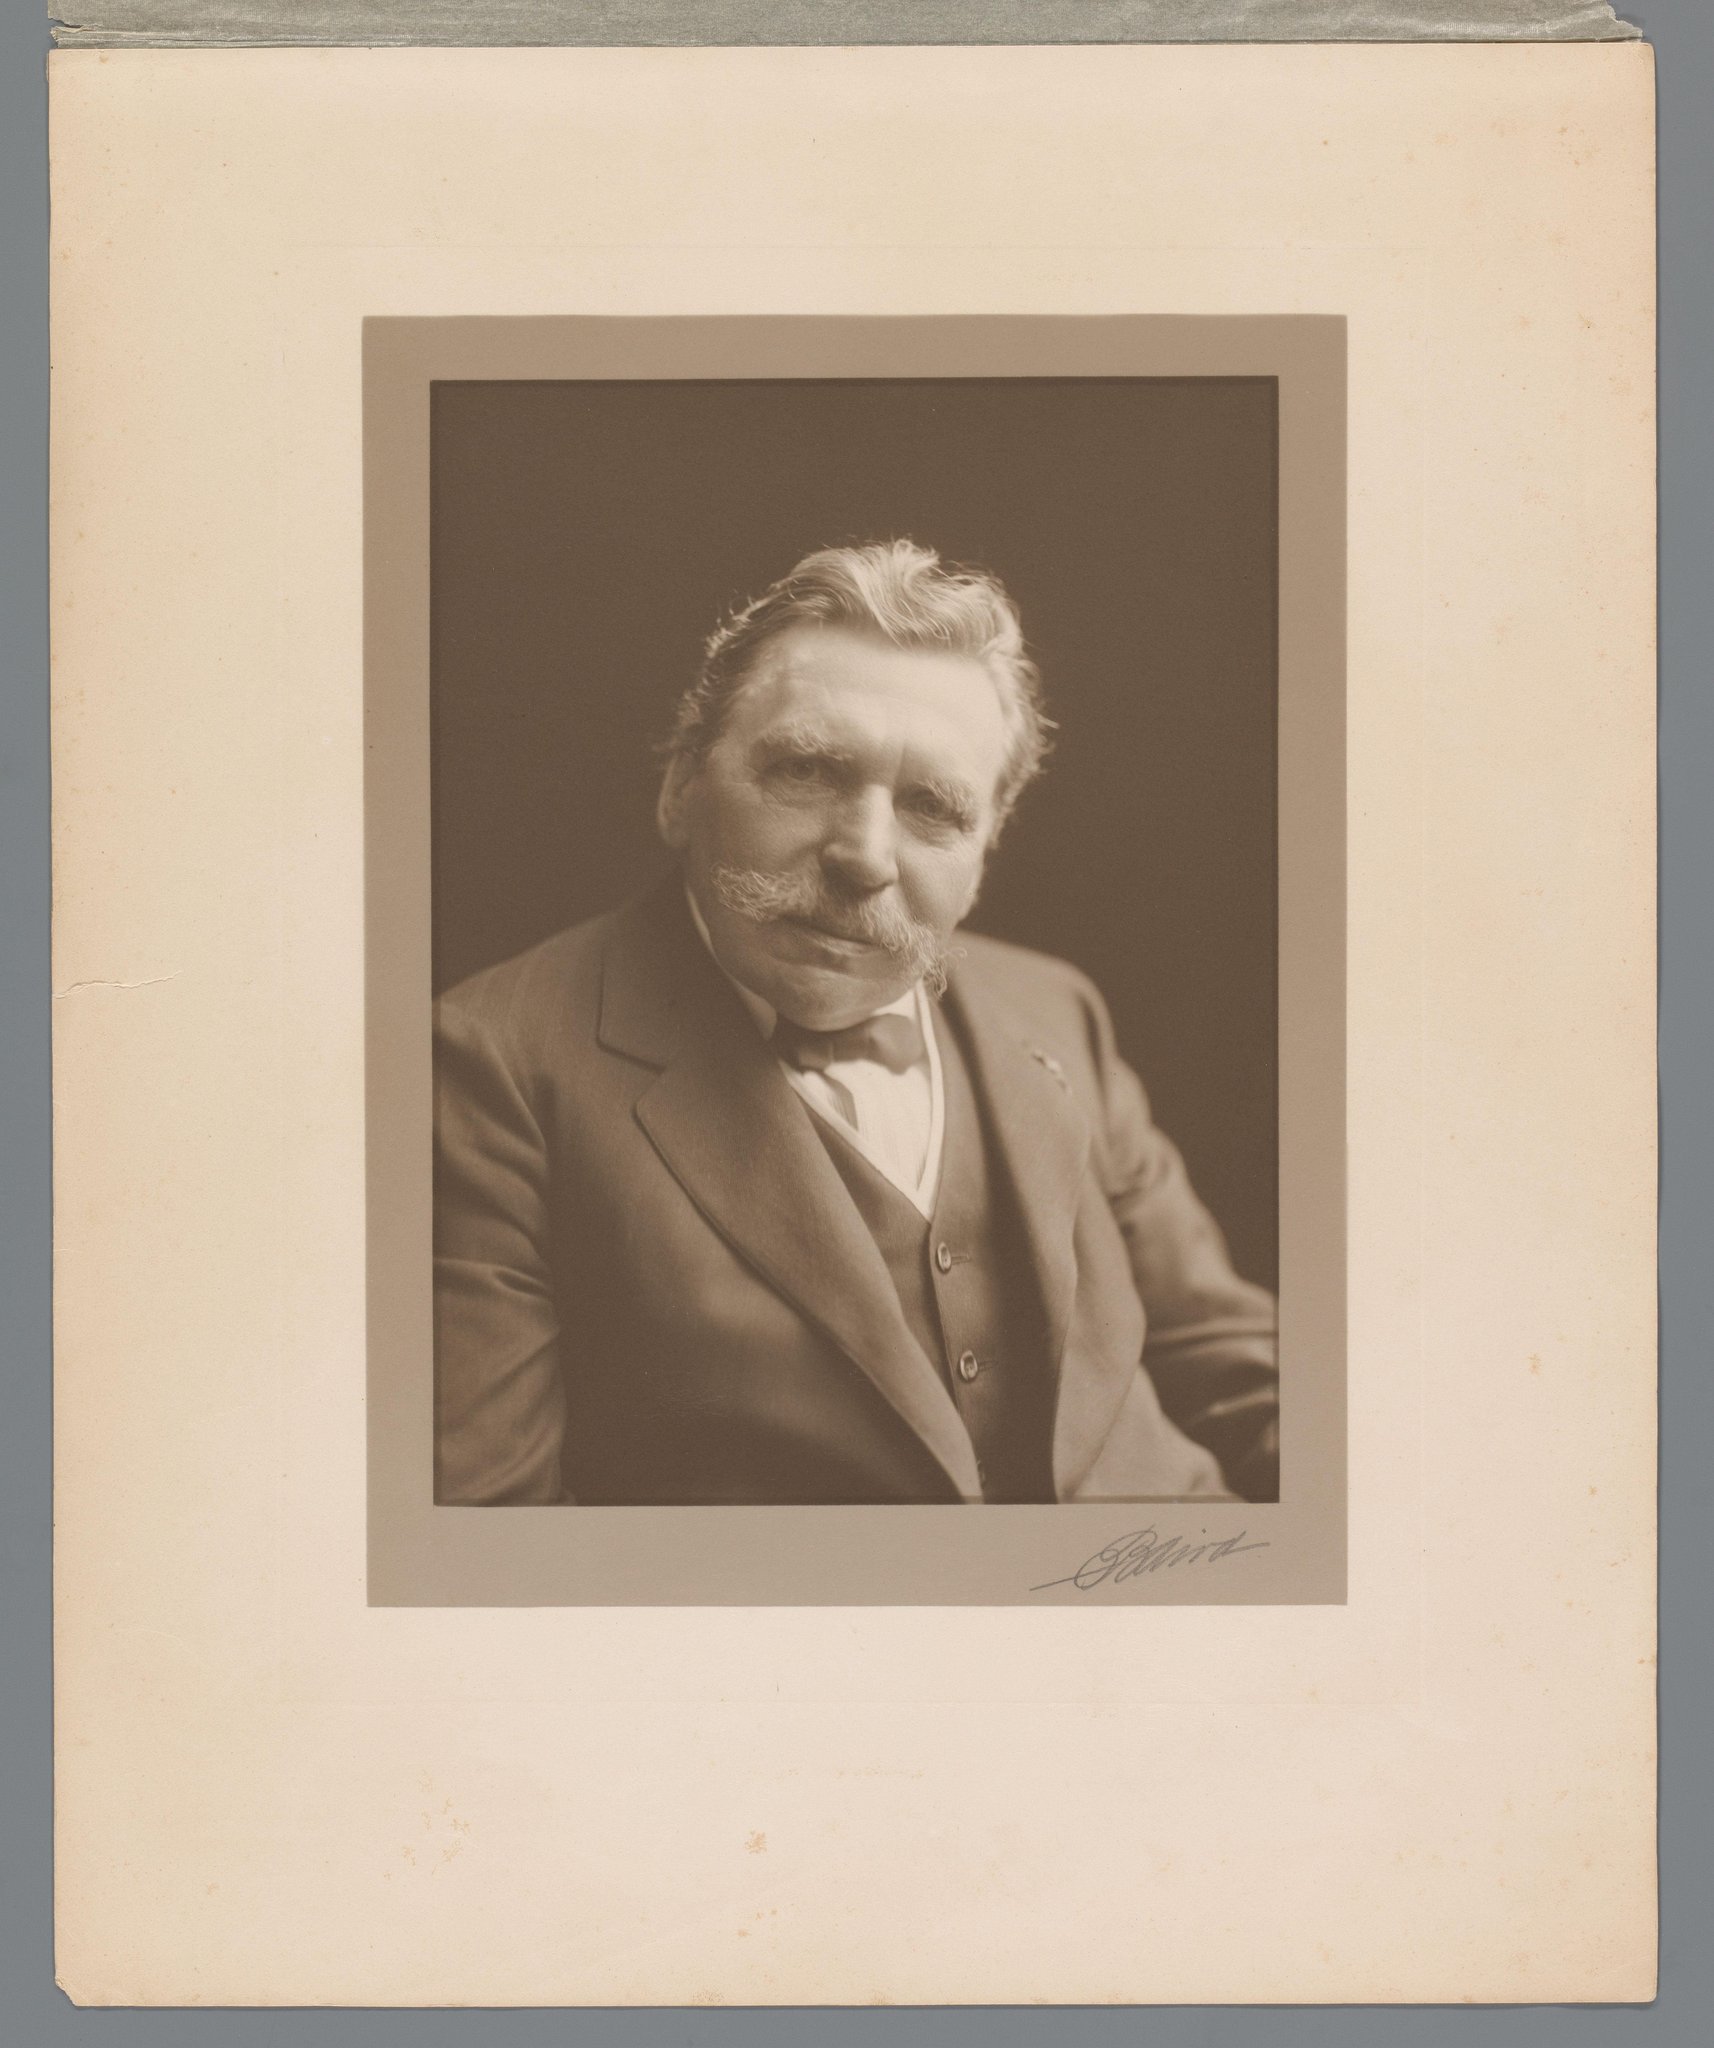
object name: photograph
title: Portret van Albert Neuhuys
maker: Anonymous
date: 1880-1914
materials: cardboard, paper, photographic support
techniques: matte daylight collodion silver print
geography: netherlands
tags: utrecht, painter, print maker, draughtsman, albert neuhuys (1844-1914)